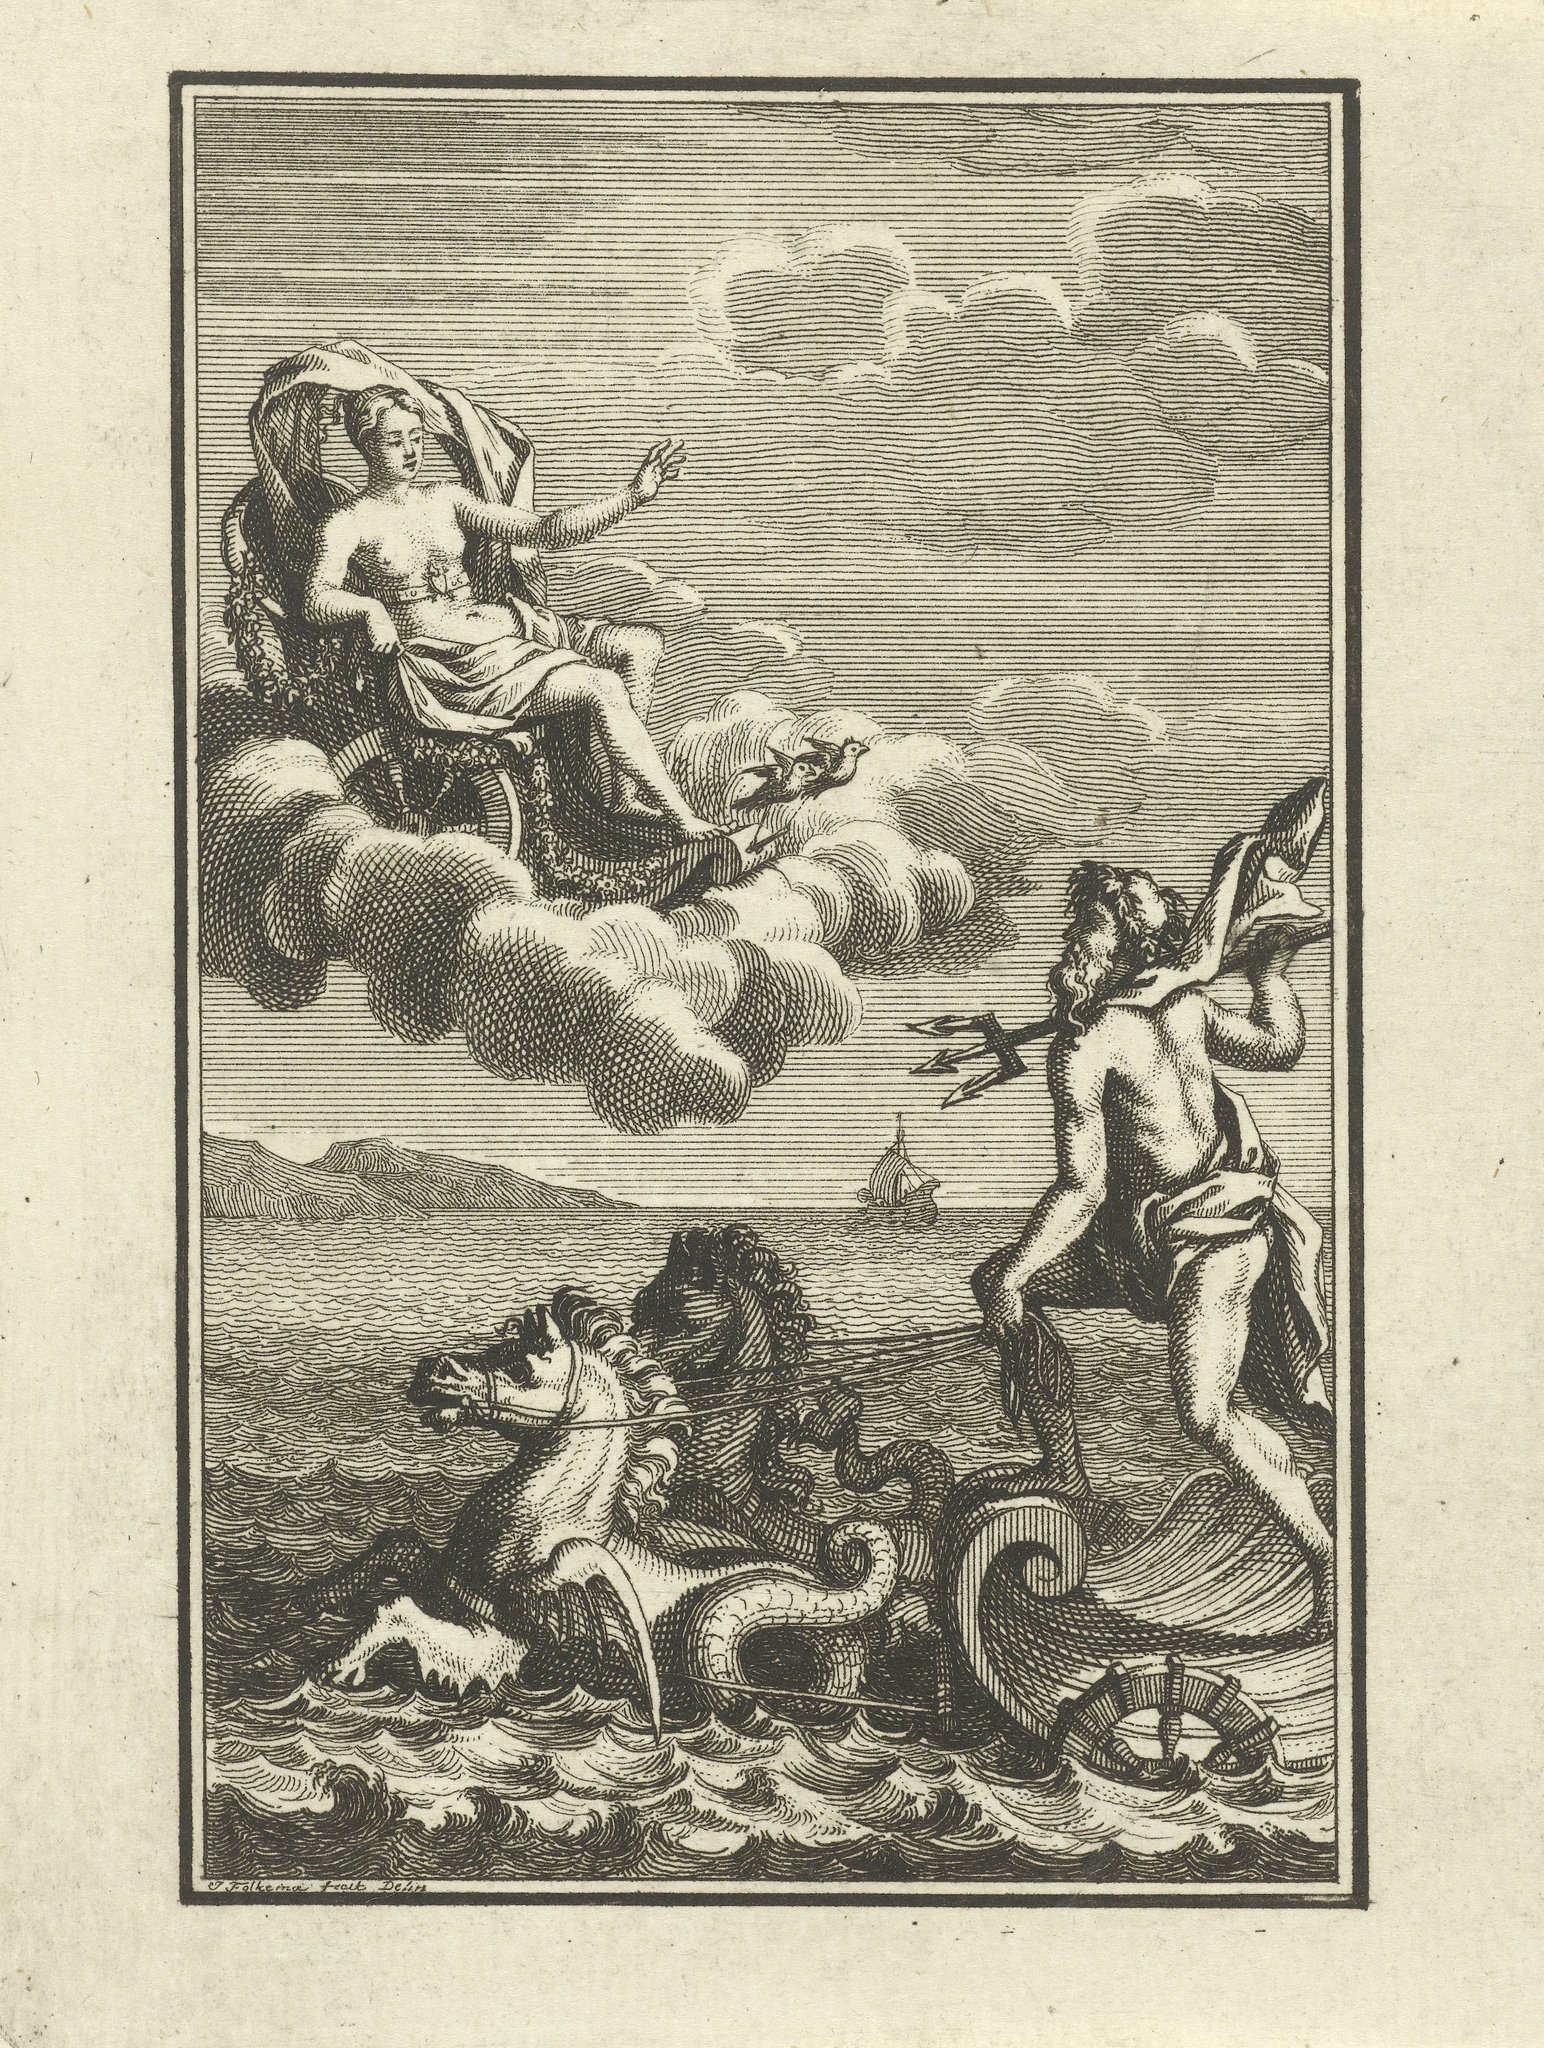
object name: print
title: Avonturen van Telemachus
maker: jacob folkema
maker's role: draughtsman, print maker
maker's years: 1692-1767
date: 1715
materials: paper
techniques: etching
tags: (story of) neptune (poseidon), (story of) venus (aphrodite), (story of) telemachus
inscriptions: collector's mark: Lugt 2228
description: Neptunus staat op een schelp en wordt voortgetrokken door zeepaarden. Hij is in gesprek met Venus die op haar wagen, voortgetrokken door vogels, uit de lucht is neergedaald. Illustratie vervaardigd bij een verhaal uit "Avonturen van Telemachus", geschreven door François de Fénélon.